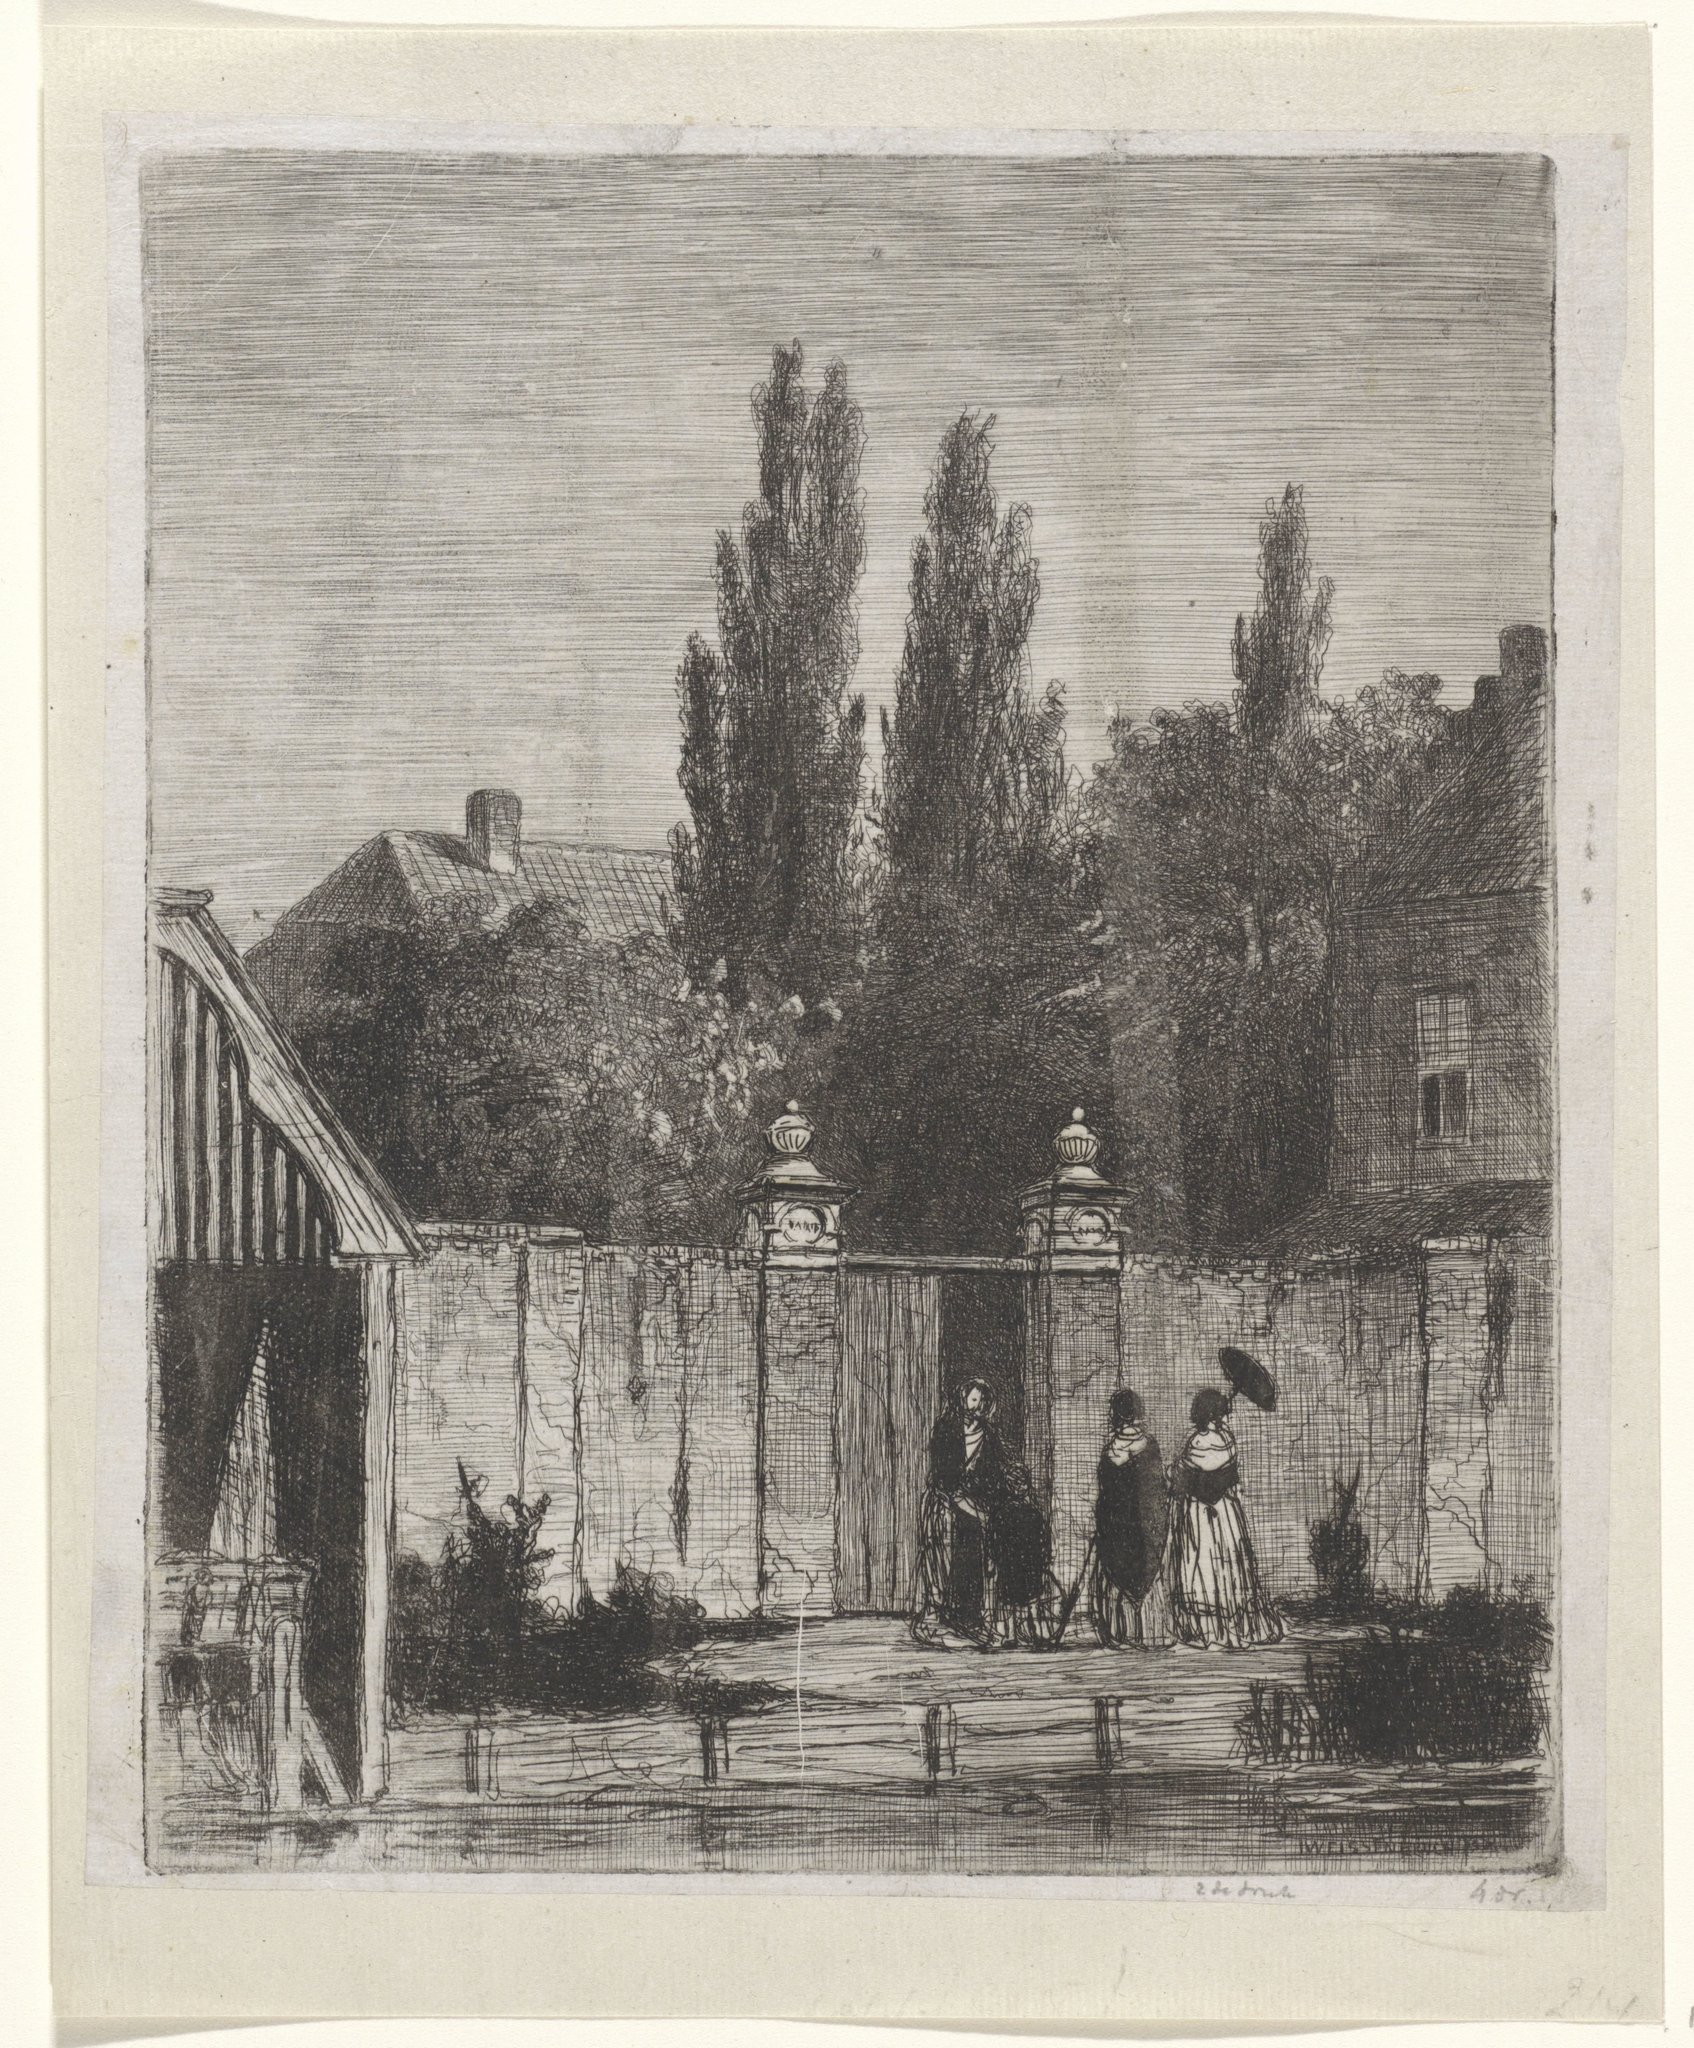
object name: print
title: Ingang van een tuin aan het Zieken te Den Haag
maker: jan weissenbruch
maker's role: painter, print maker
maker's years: 1822-1880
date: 1850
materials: paper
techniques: etching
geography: the hague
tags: roof-covering, urban housing, trees, seating furniture, adult woman, fenced or walled garden; 'hortus conclusus', child, walking, parasol, sunshade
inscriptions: date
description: Voor de ingang van een ommuurde tuin staan drie vrouwen en een kind. Twee van hen houden een parasol vast. Links staat meubilair onder een overkapping en in de verte zijn huizen weergegeven.